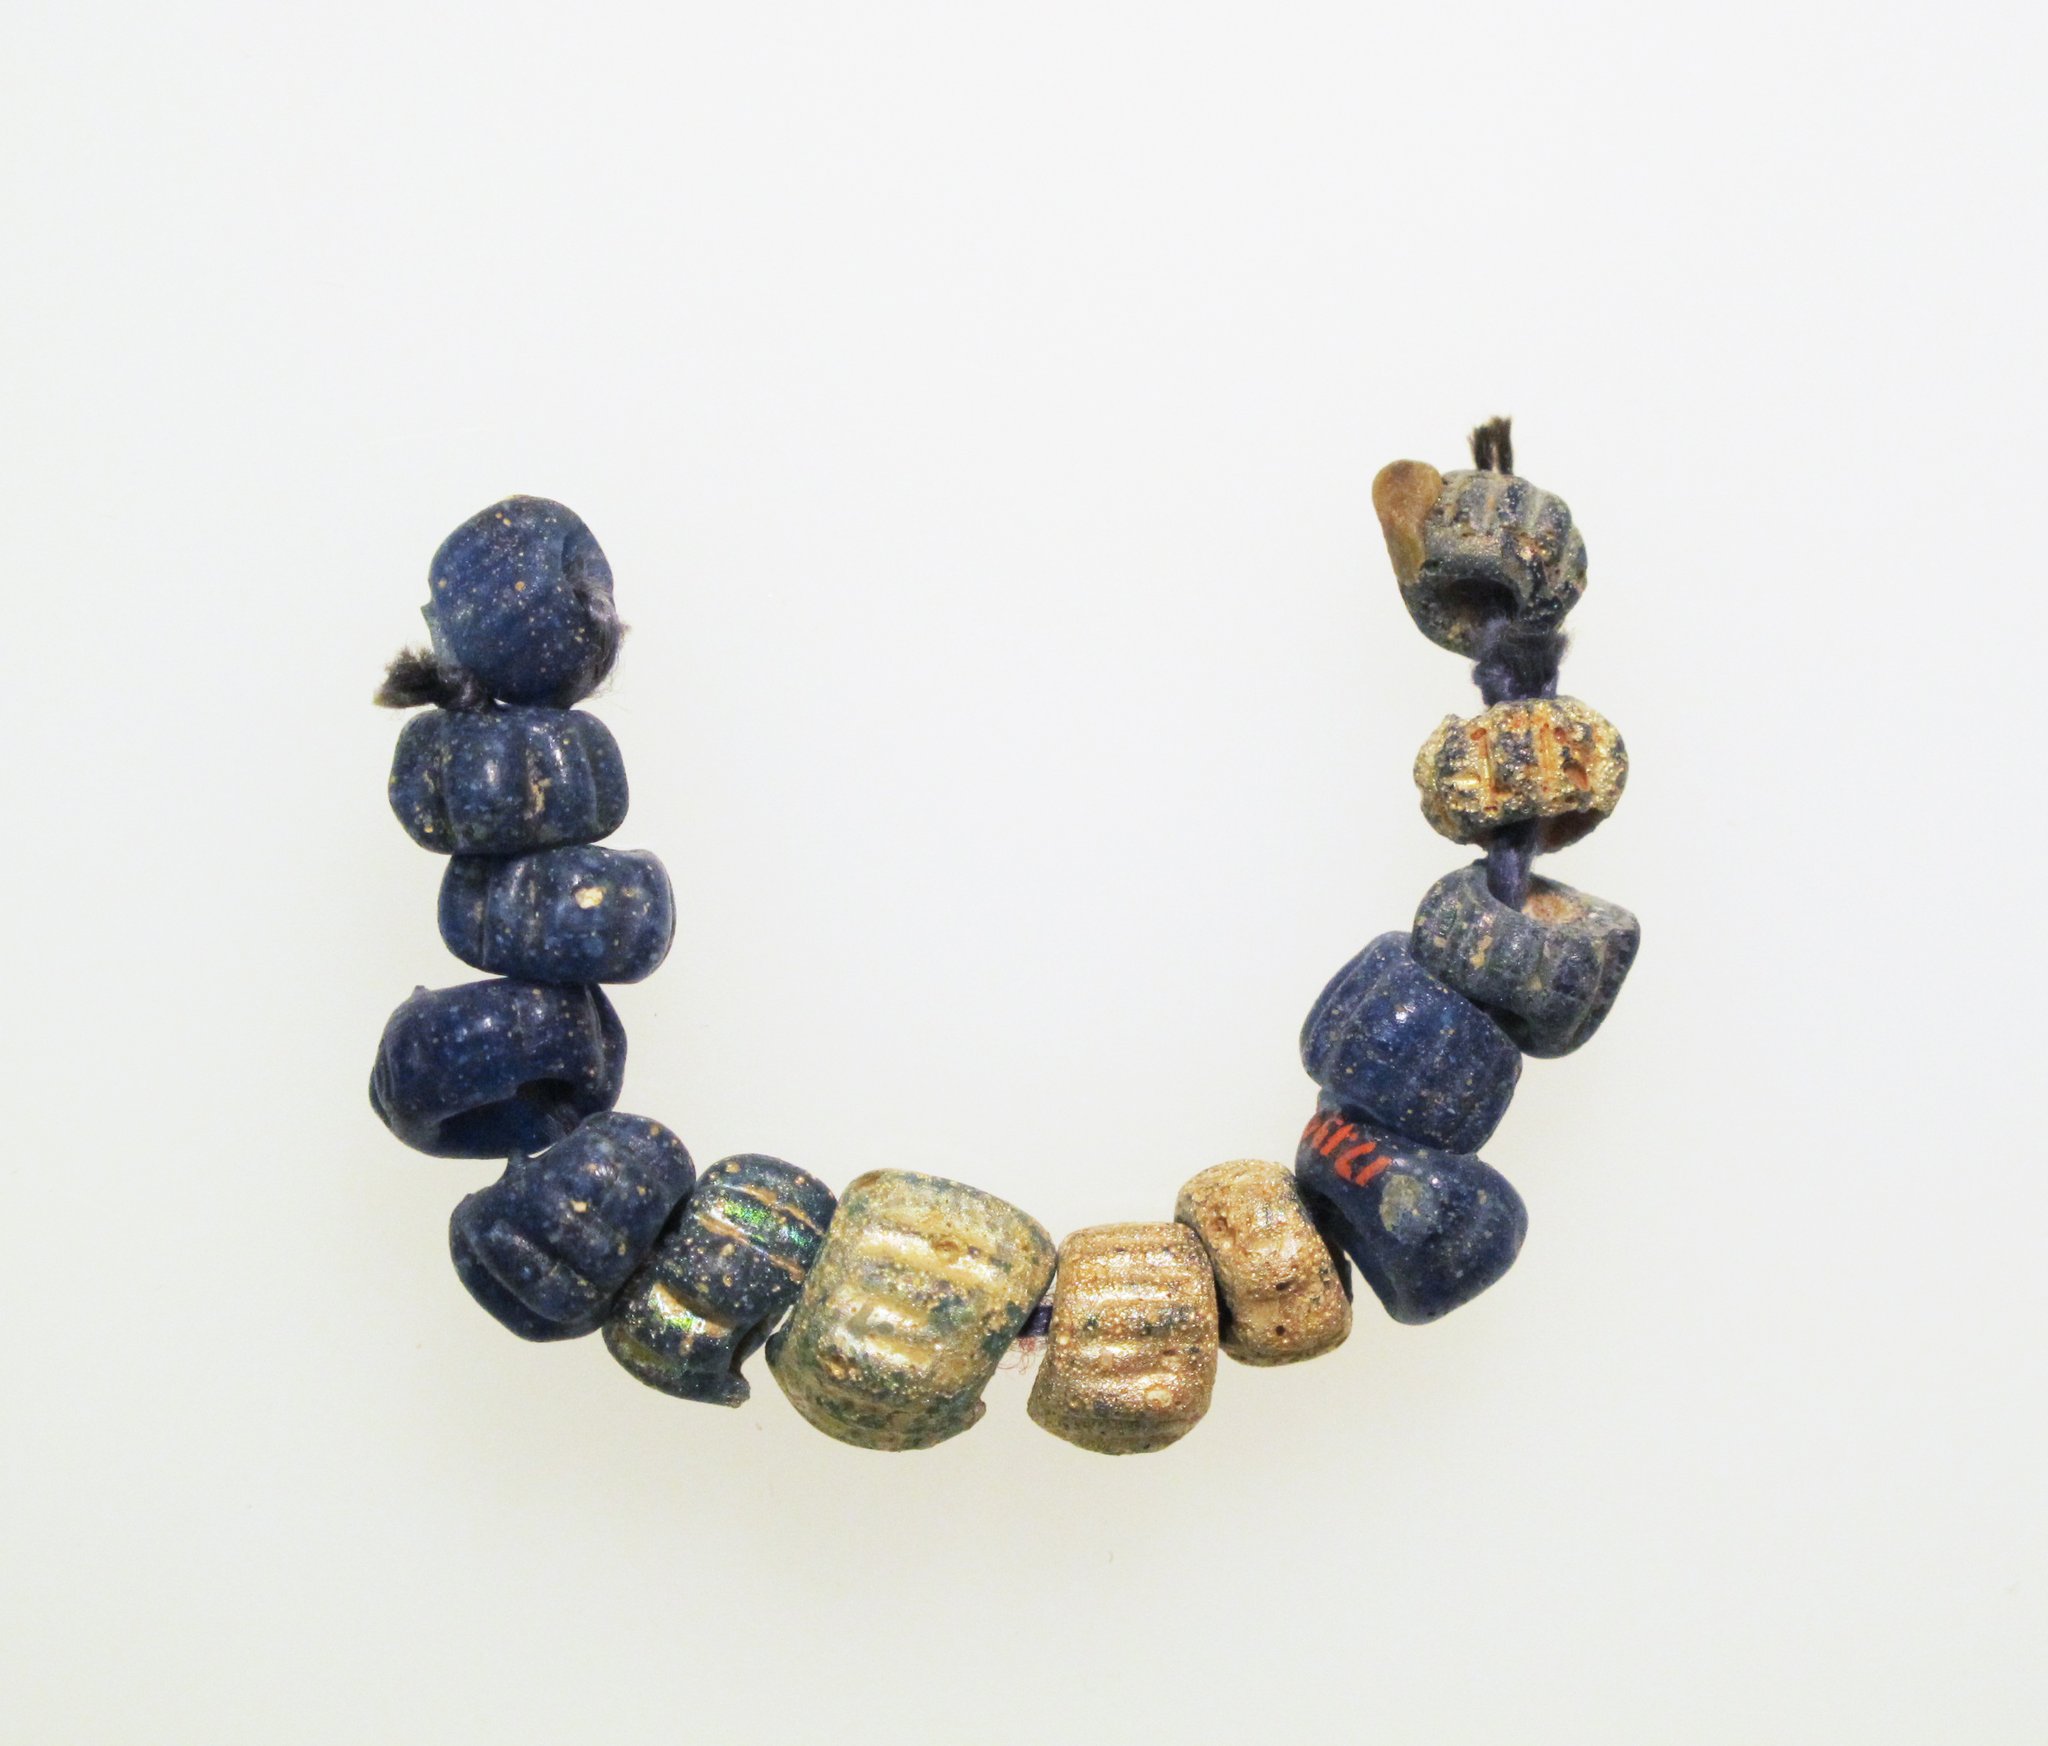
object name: bead, 14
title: Beads, 14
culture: roman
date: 670 BCE-330 CE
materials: glass